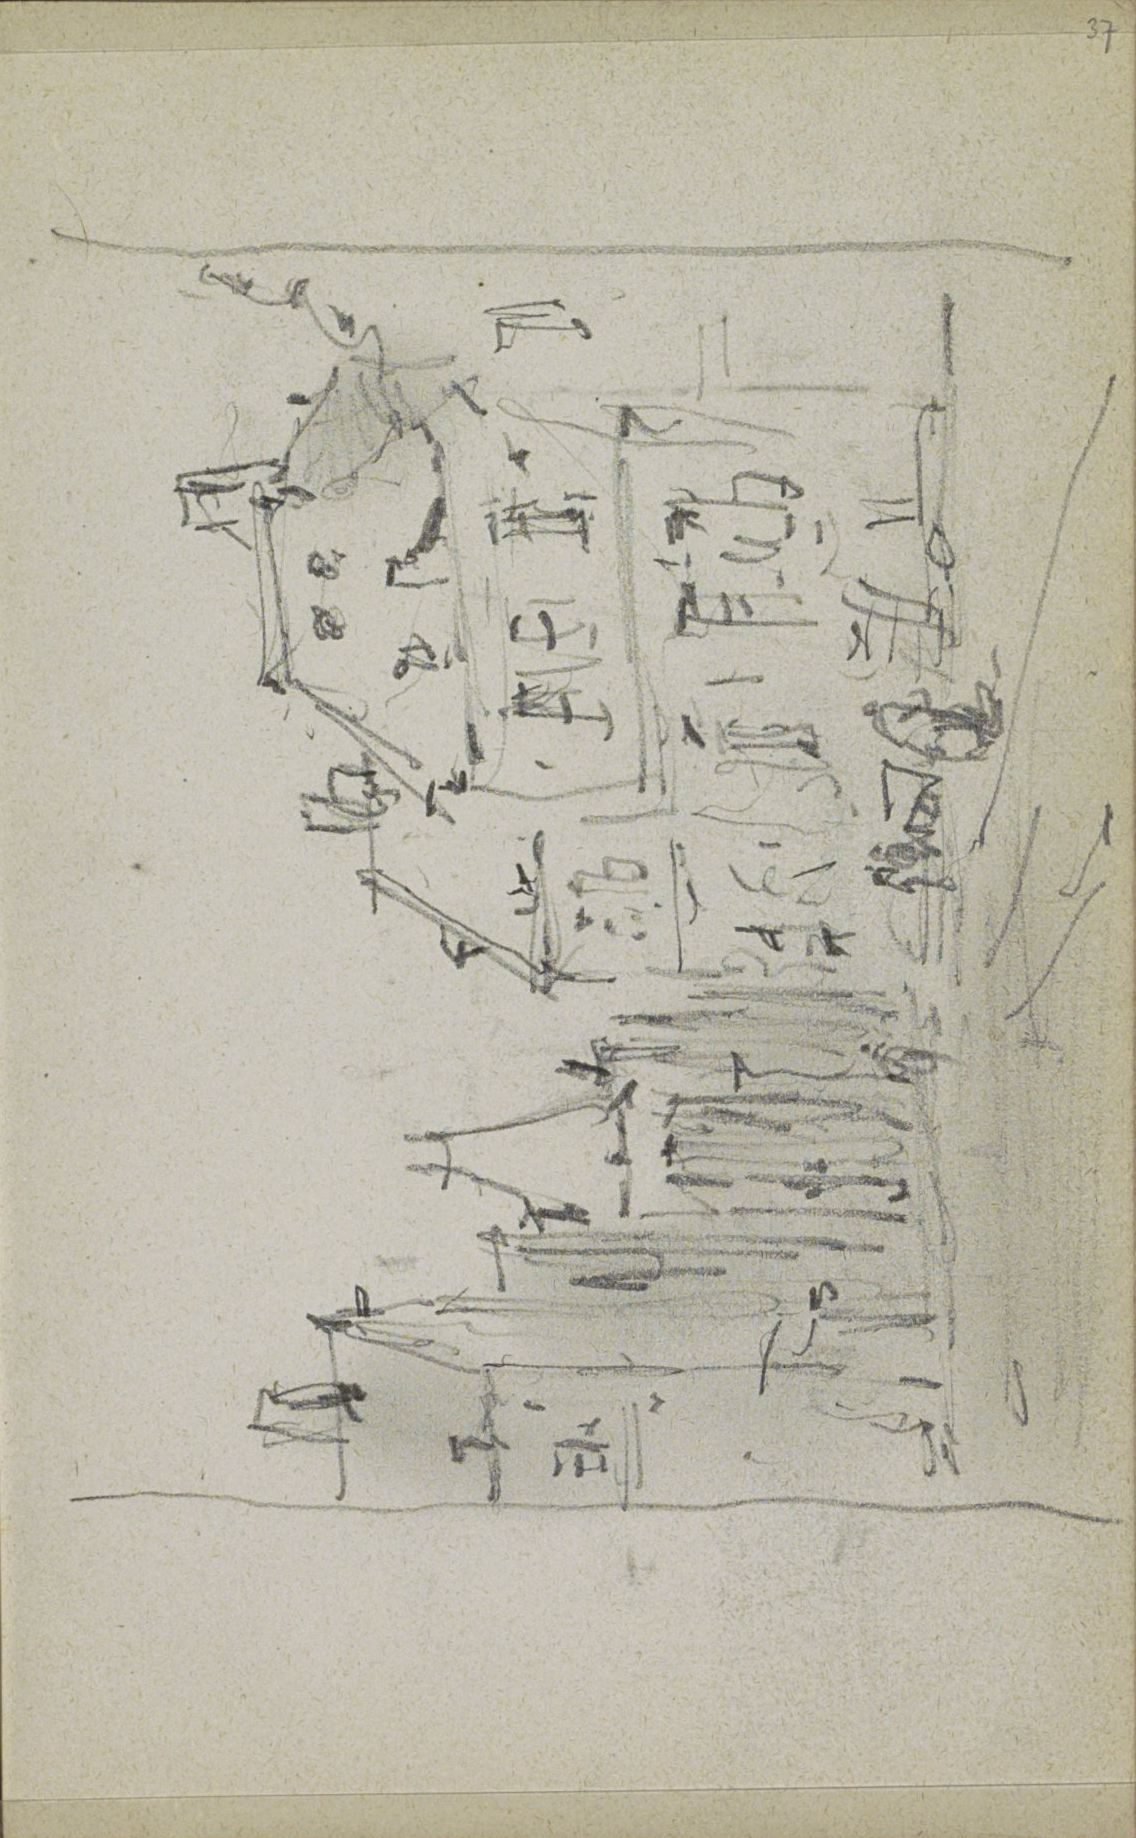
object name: sketchbook leaf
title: Stadsgezicht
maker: adrianus eversen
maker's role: draughtsman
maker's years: 1818-1897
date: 1828-1897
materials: paper, pencil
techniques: stumping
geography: netherlands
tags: square, place, circus, etc., urban housing, street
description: Gezicht op gebouwen aan een straat of plein. In het midden figuren. Blad 37 recto uit een schetsboek met 58 bladen.